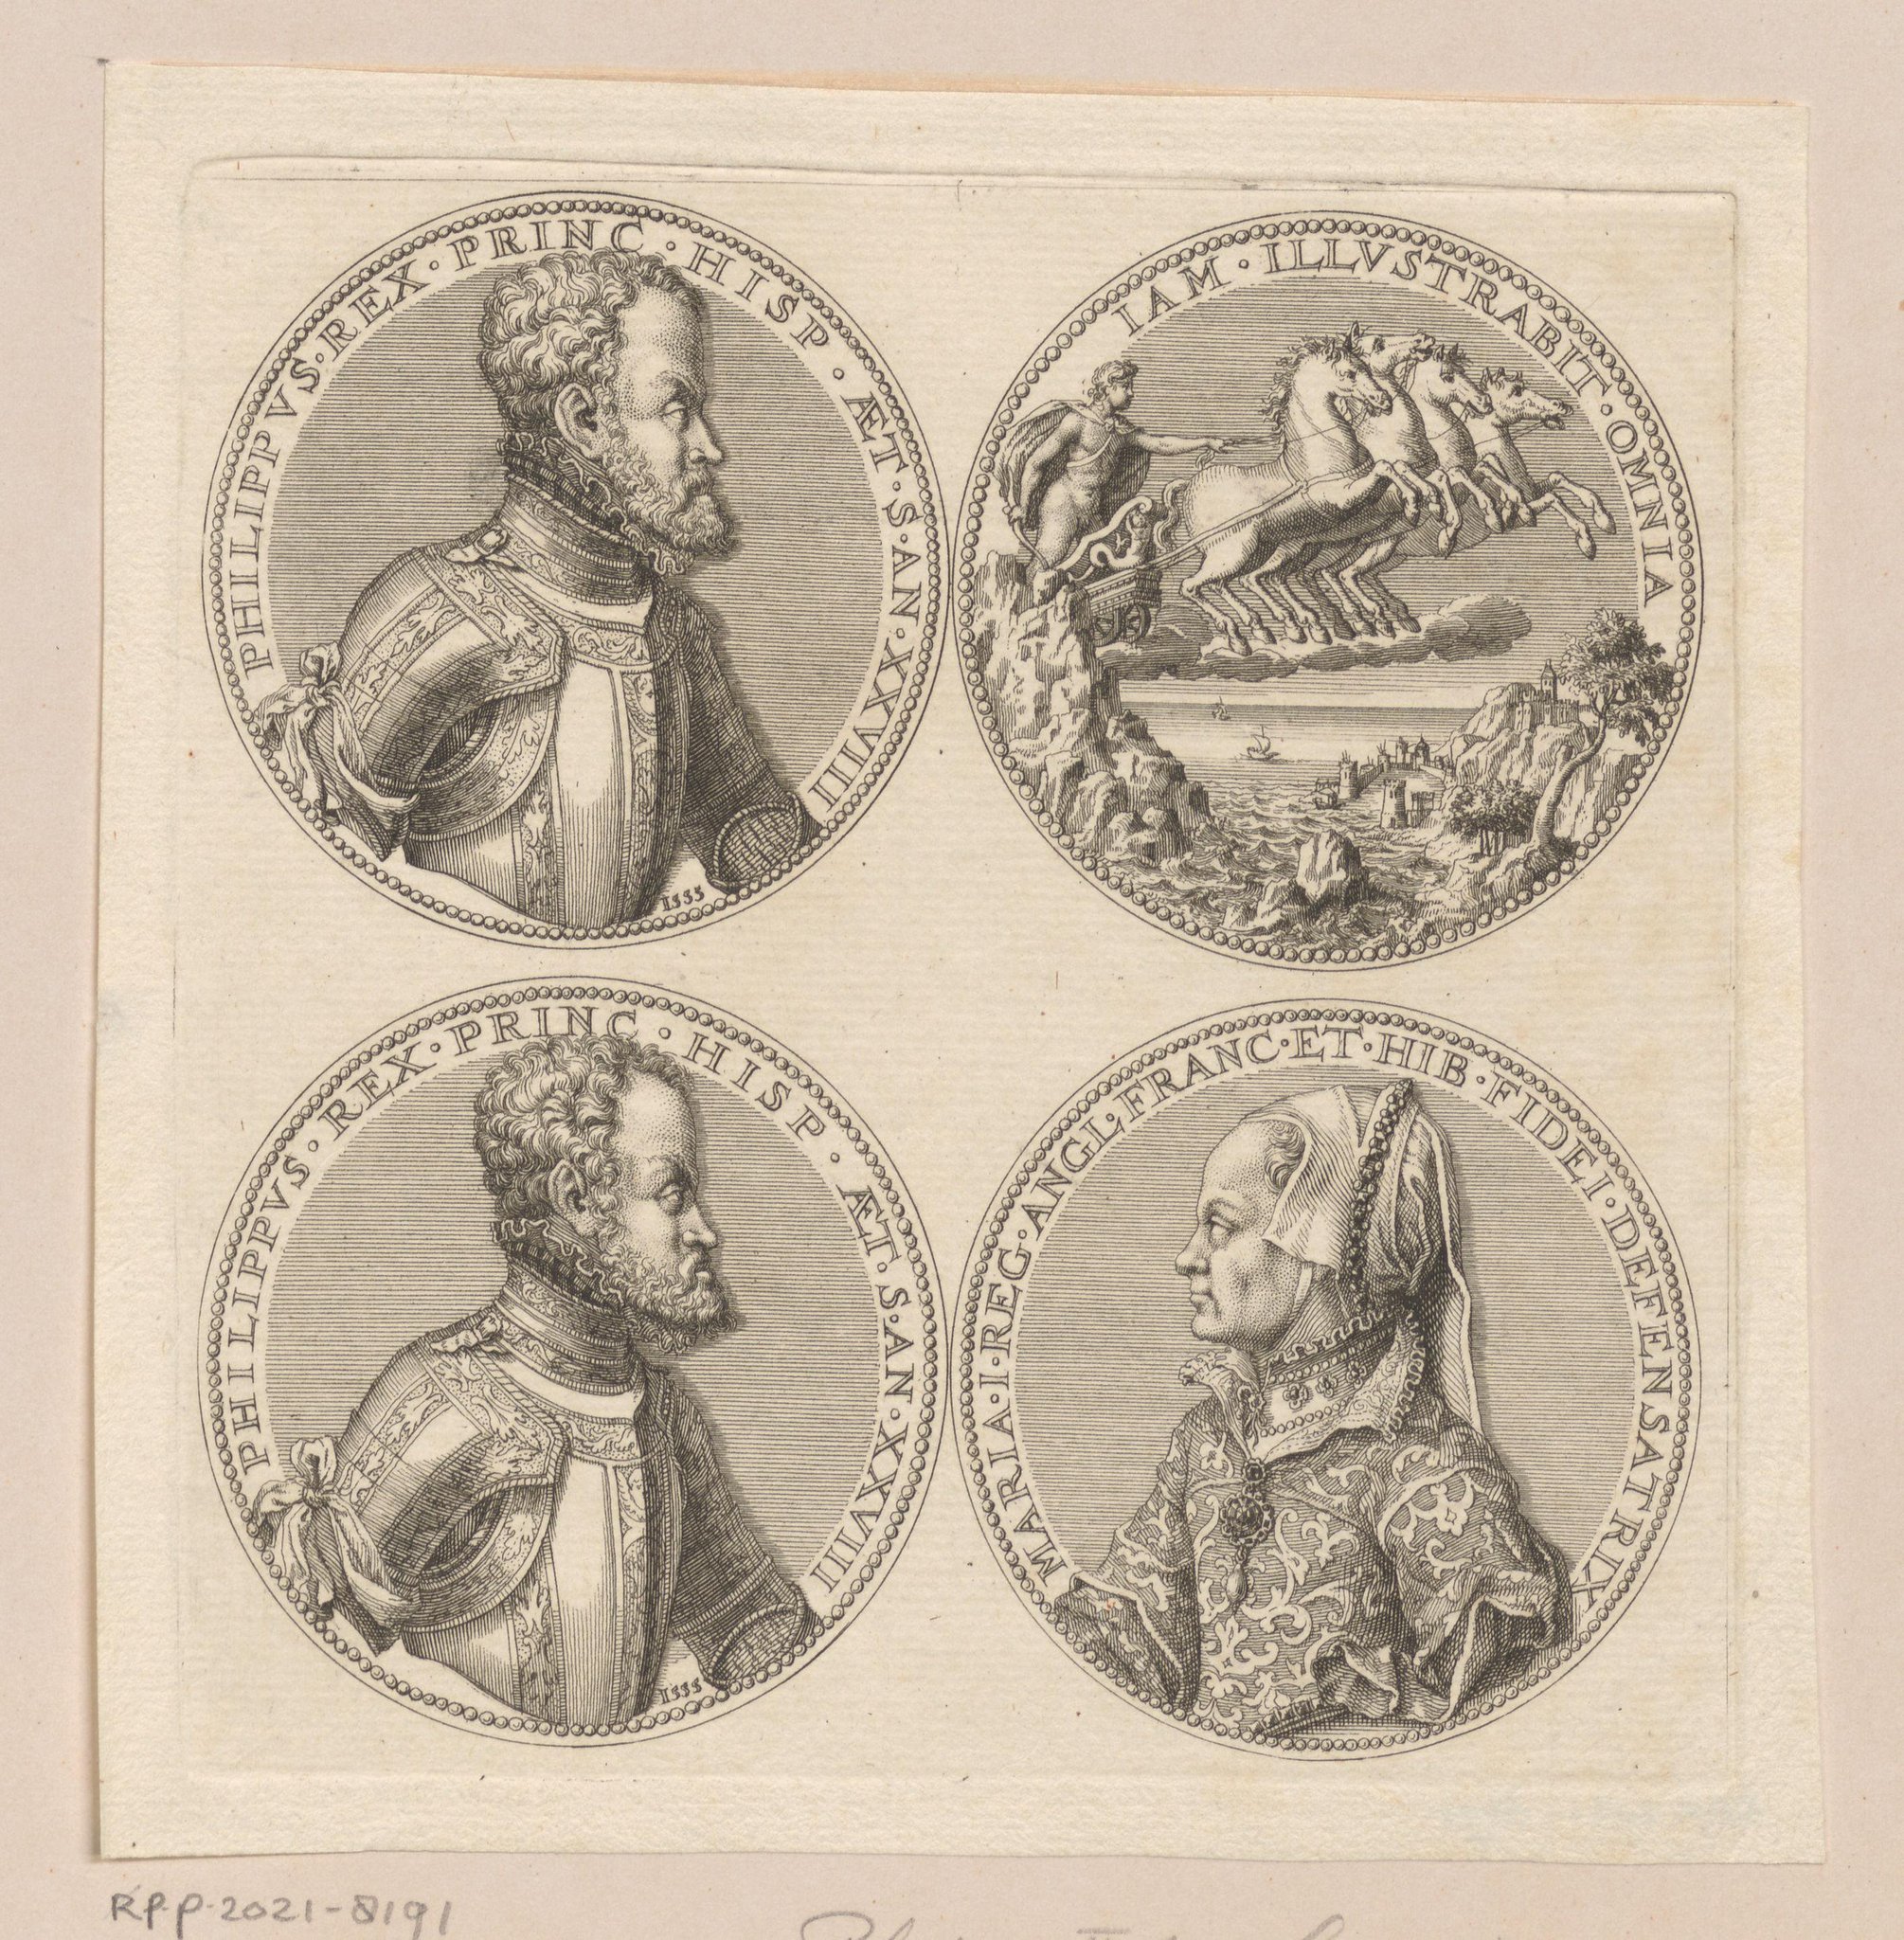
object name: print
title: Penningen met het portret van Filips II en Maria I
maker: Anonymous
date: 1723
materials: paper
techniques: engraving, etching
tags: philip ii of spain, london, historical persons, coin, horse, coast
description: Prent met tekst op verso gebruikt in: Loon, Gerard van. Beschryving der Nederlandsche Historipenningen (...). Den Haag: Christiaan van Lom, Isaac Vaillant, Pieter Gosse, Rutger Alberts en Pieter de Hondt, 1723, dl. 1.